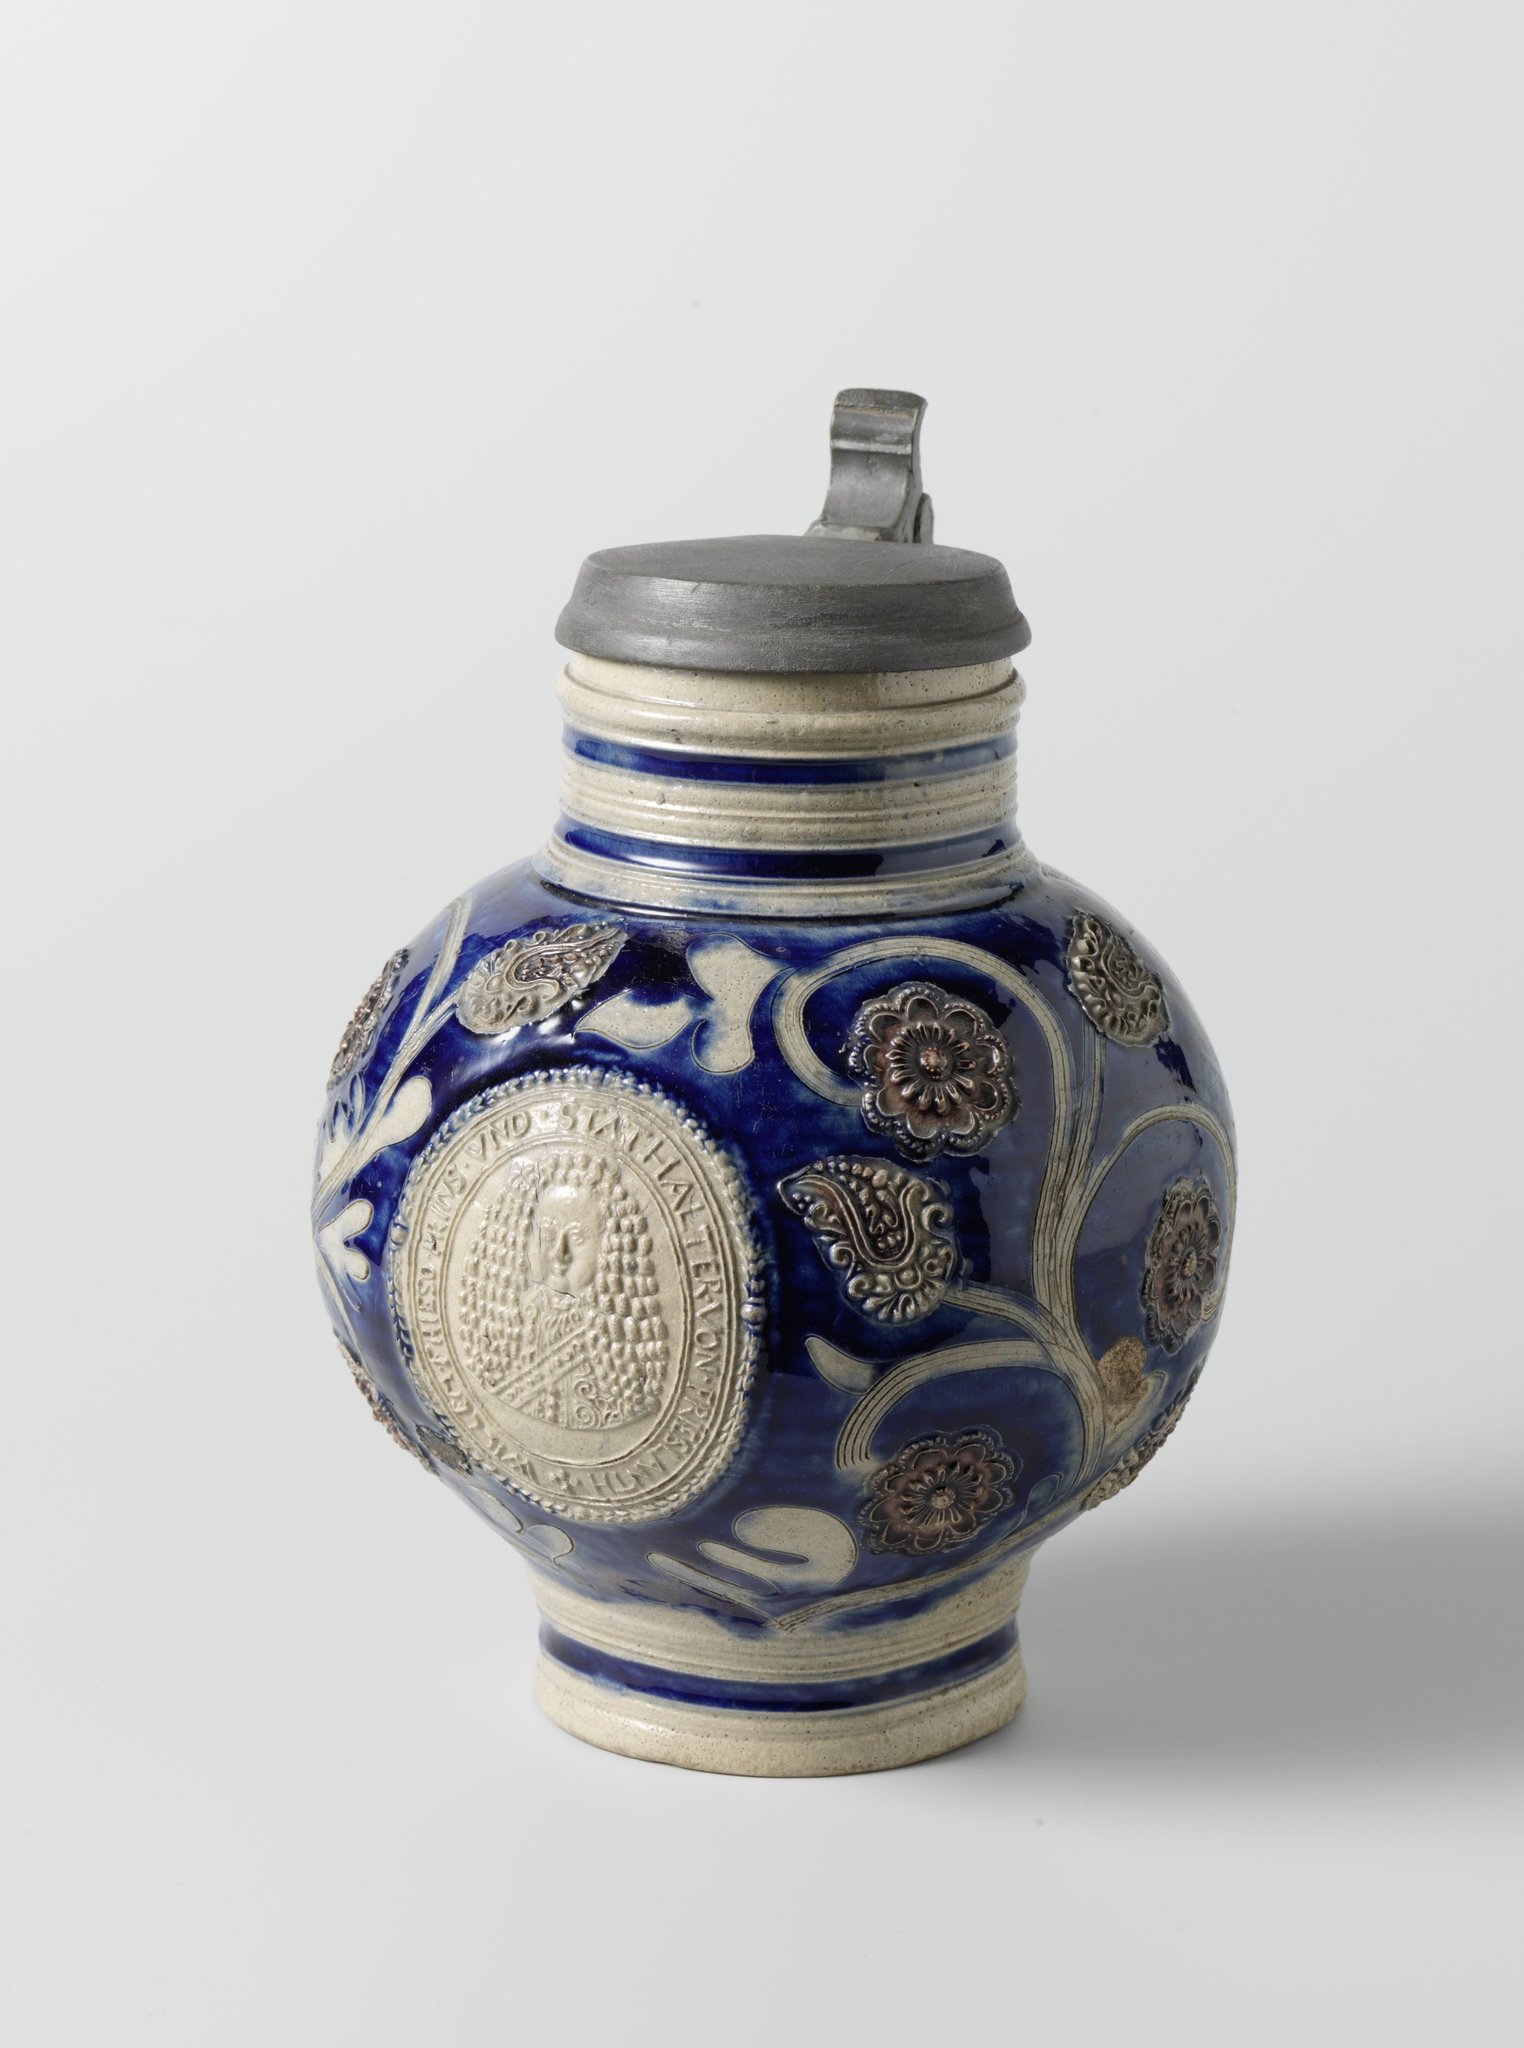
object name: jug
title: Jug with a portrait of prince Willem Friso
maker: Anonymous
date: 1650-1699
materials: cobalt, glaze, mineral, stoneware, tin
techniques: firing, forming, relief, turning, vitrification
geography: westerwald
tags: johan willem friso (prins van oranje-nassau), foliage, tendrils, branches ~ ornament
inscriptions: inscription: ‘WILLEM FRIESO PRINS UND STATHALTER VON FRIESLANTH’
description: translation of inscription: William Friso, Prince and Stadtholder of Friesland